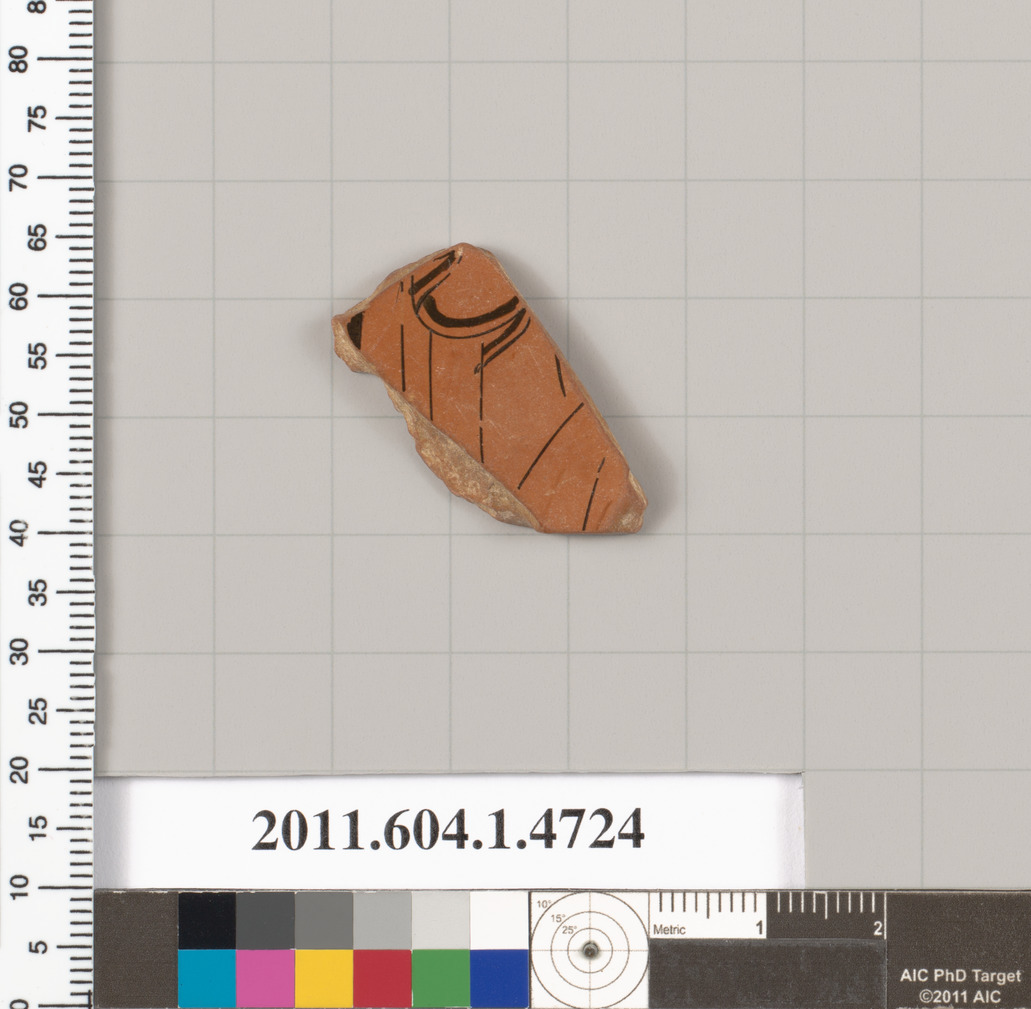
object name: kylix fragment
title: Terracotta fragment of a kylix (drinking cup)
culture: greek, attic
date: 475-451 BCE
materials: terracotta